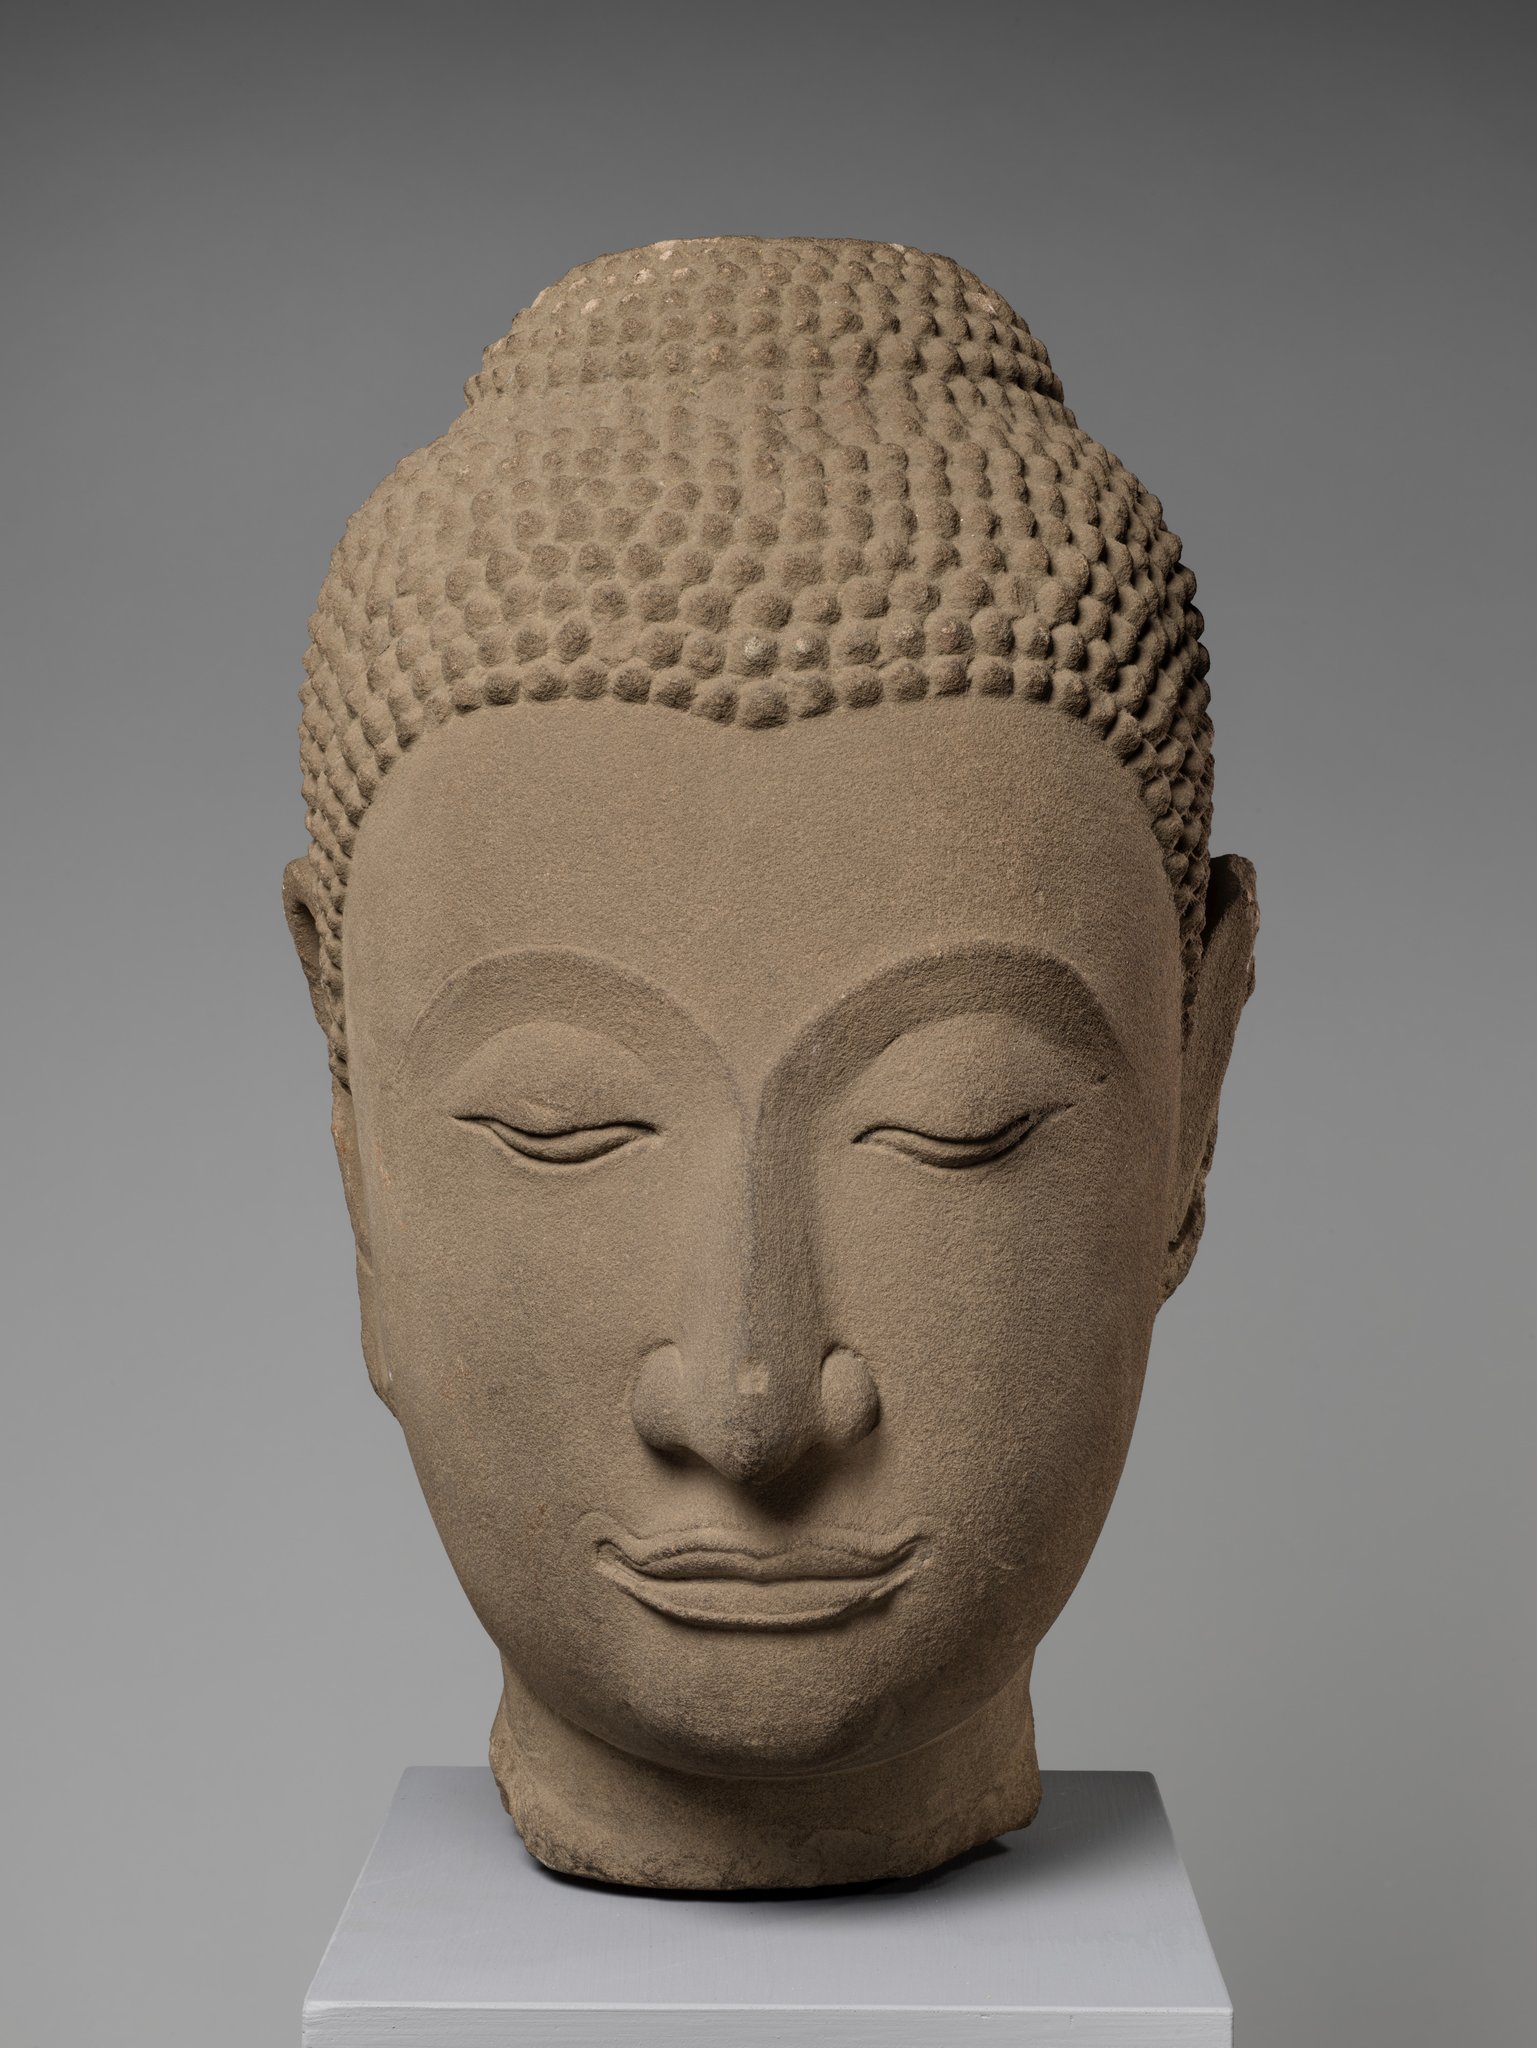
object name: head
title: Head of Gautama Buddha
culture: thai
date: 1501-1700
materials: stone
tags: heads,buddhism,buddha